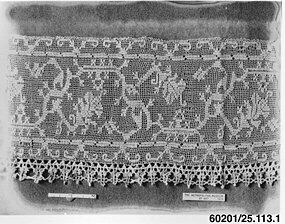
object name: strip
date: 1601-1733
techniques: lace, embroidery